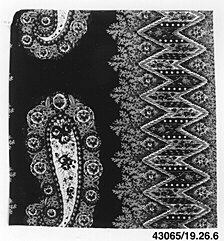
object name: sample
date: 1840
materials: cotton